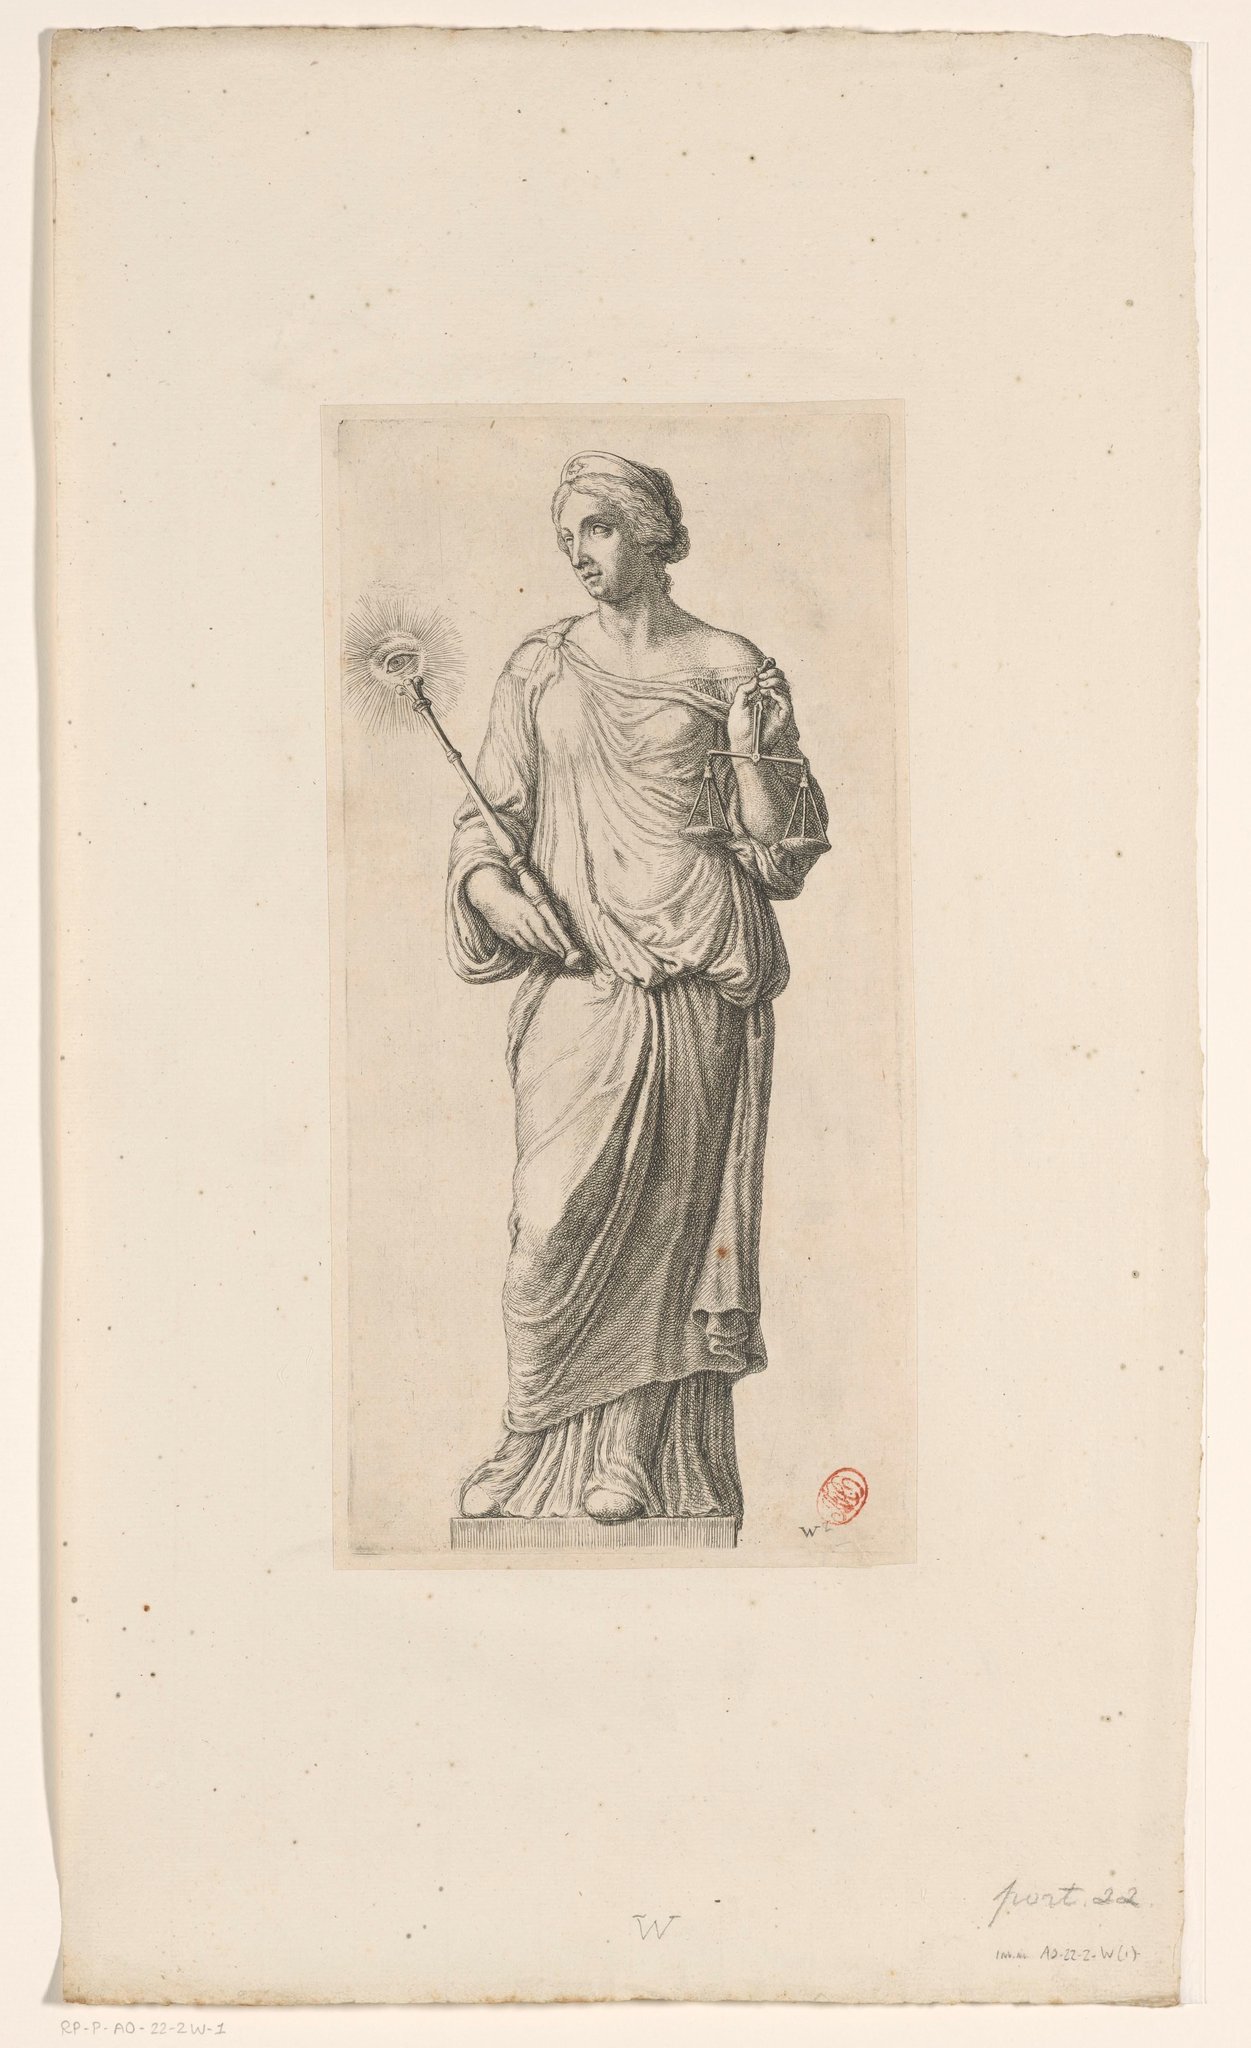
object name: book illustration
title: Beeld van Justitia (Gerechtigheid) op de voorgevel van het Stadhuis op de Dam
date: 1663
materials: paper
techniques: engraving, etching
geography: amsterdam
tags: justice, 'justitia'; 'giustitia divina' (ripa) ~ one of the four cardinal virtues, justitia (justice) as roman personification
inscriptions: collector's mark: Lugt 195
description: Prent gebruikt in: Secunca pars Praecipuarum effigierum ac ornamentorum amplissime Curiae Amstelrodamensis maiori ex parte in cadido marmore effectorum per Artum Quellinium eiusdem Civitatis Statuarium / Het tweede deel Van de voornaemste Statuen ende Cieraten van 't konst-rijcke Stadt-huys van Amstelredam 'tmeeste in Marmer gemaeckt door Artus Quellinus Beelthouwer der voorseyde Stadt. Amsterdam: Artus Quellinus (I), 1663. Zie RP-P-AO-22-2-1 voor bijhorende titelpagina. Zie RP-P-AO-22-2-2 voor bijhorend register. Zie RP-P-AO-22-2A, RP-P-AO-22-2B, RP-P-AO-22-2C-1, RP-P-AO-22-2C-2, RP-P-AO-22-2C-3, RP-P-AO-22-2C-4, RP-P-AO-22-2D-1, RP-P-AO-22-2D-2, RP-P-AO-22-2D-3, RP-P-AO-22-2E-1, RP-P-AO-22-2E-2, RP-P-AO-22-2E-3, RP-P-AO-22-2E-4, RP-P-AO-22-2F-1, RP-P-AO-22-2F-2, RP-P-AO-22-2F-3, RP-P-AO-22-2G, RP-P-AO-22-2H, RP-P-AO-22-2I, RP-P-AO-22-2K, RP-P-AO-22-2L, RP-P-AO-22-2M, RP-P-AO-22-2N, RP-P-AO-22-2O-1, RP-P-AO-22-2O-2, RP-P-AO-22-2O-3, RP-P-AO-22-2O-4, RP-P-AO-22-2O-5, RP-P-AO-22-2O-6, RP-P-AO-22-2O-7, RP-P-AO-22-2P-1, RP-P-AO-22-2P-2, RP-P-AO-22-2Q-1, RP-P-AO-22-2Q-2, RP-P-AO-22-2Q-3, RP-P-AO-22-2R-1, RP-P-AO-22-2R-2, RP-P-AO-22-2R-3, RP-P-AO-22-2S, RP-P-AO-22-2T-1, RP-P-AO-22-2T-2, RP-P-AO-22-2T-3, RP-P-AO-22-2T-4, RP-P-AO-22-2V-1, RP-P-AO-22-2V-2, RP-P-AO-22-2W-2, RP-P-AO-22-2X-1, RP-P-AO-22-2X-2 en RP-P-AO-22-2X-3 voor andere prenten uit deze publicatie. Zelfde staat van prent ook gebruikt in: Secunca pars Praecipuarum effigierum ac ornamentorum amplissime Curiae Amstelrodamensis maiori ex parte in cadido marmore effectorum per Artum Quellinium eiusdem Civitatis Statuarium / Het tweede deel Van de voornaemste Statuen ende Cieraten van 't konst-rijcke Stadt-huys van Amstelredam 'tmeeste in Marmer gemaeckt door Artus Quellinus Beelthouwer der voorseyde Stadt. Amsterdam: Frederik de Wit, 1668. Latere staat van prent ook gebruikt in: Architecture peinture et sculpture de la Maison de Ville d'Amsterdam, representee en CIX. figures en taille-douce (…). Amsterdam: David Mortier, 1719. En in: Architecture peinture et sculpture de la Maison de Ville d'Amsterdam, representee en CIX. figures en taille-douce (…). Amsterdam: Gerard Valck, 1719. En in: Bouw schilder en beeldhouwkonst, van het Stadhuis te Amsteldam, vertoont in CIX figuuren (…). Amsterdam: Covens & Mortier & Covens Jr., s.a. (1774-1783).